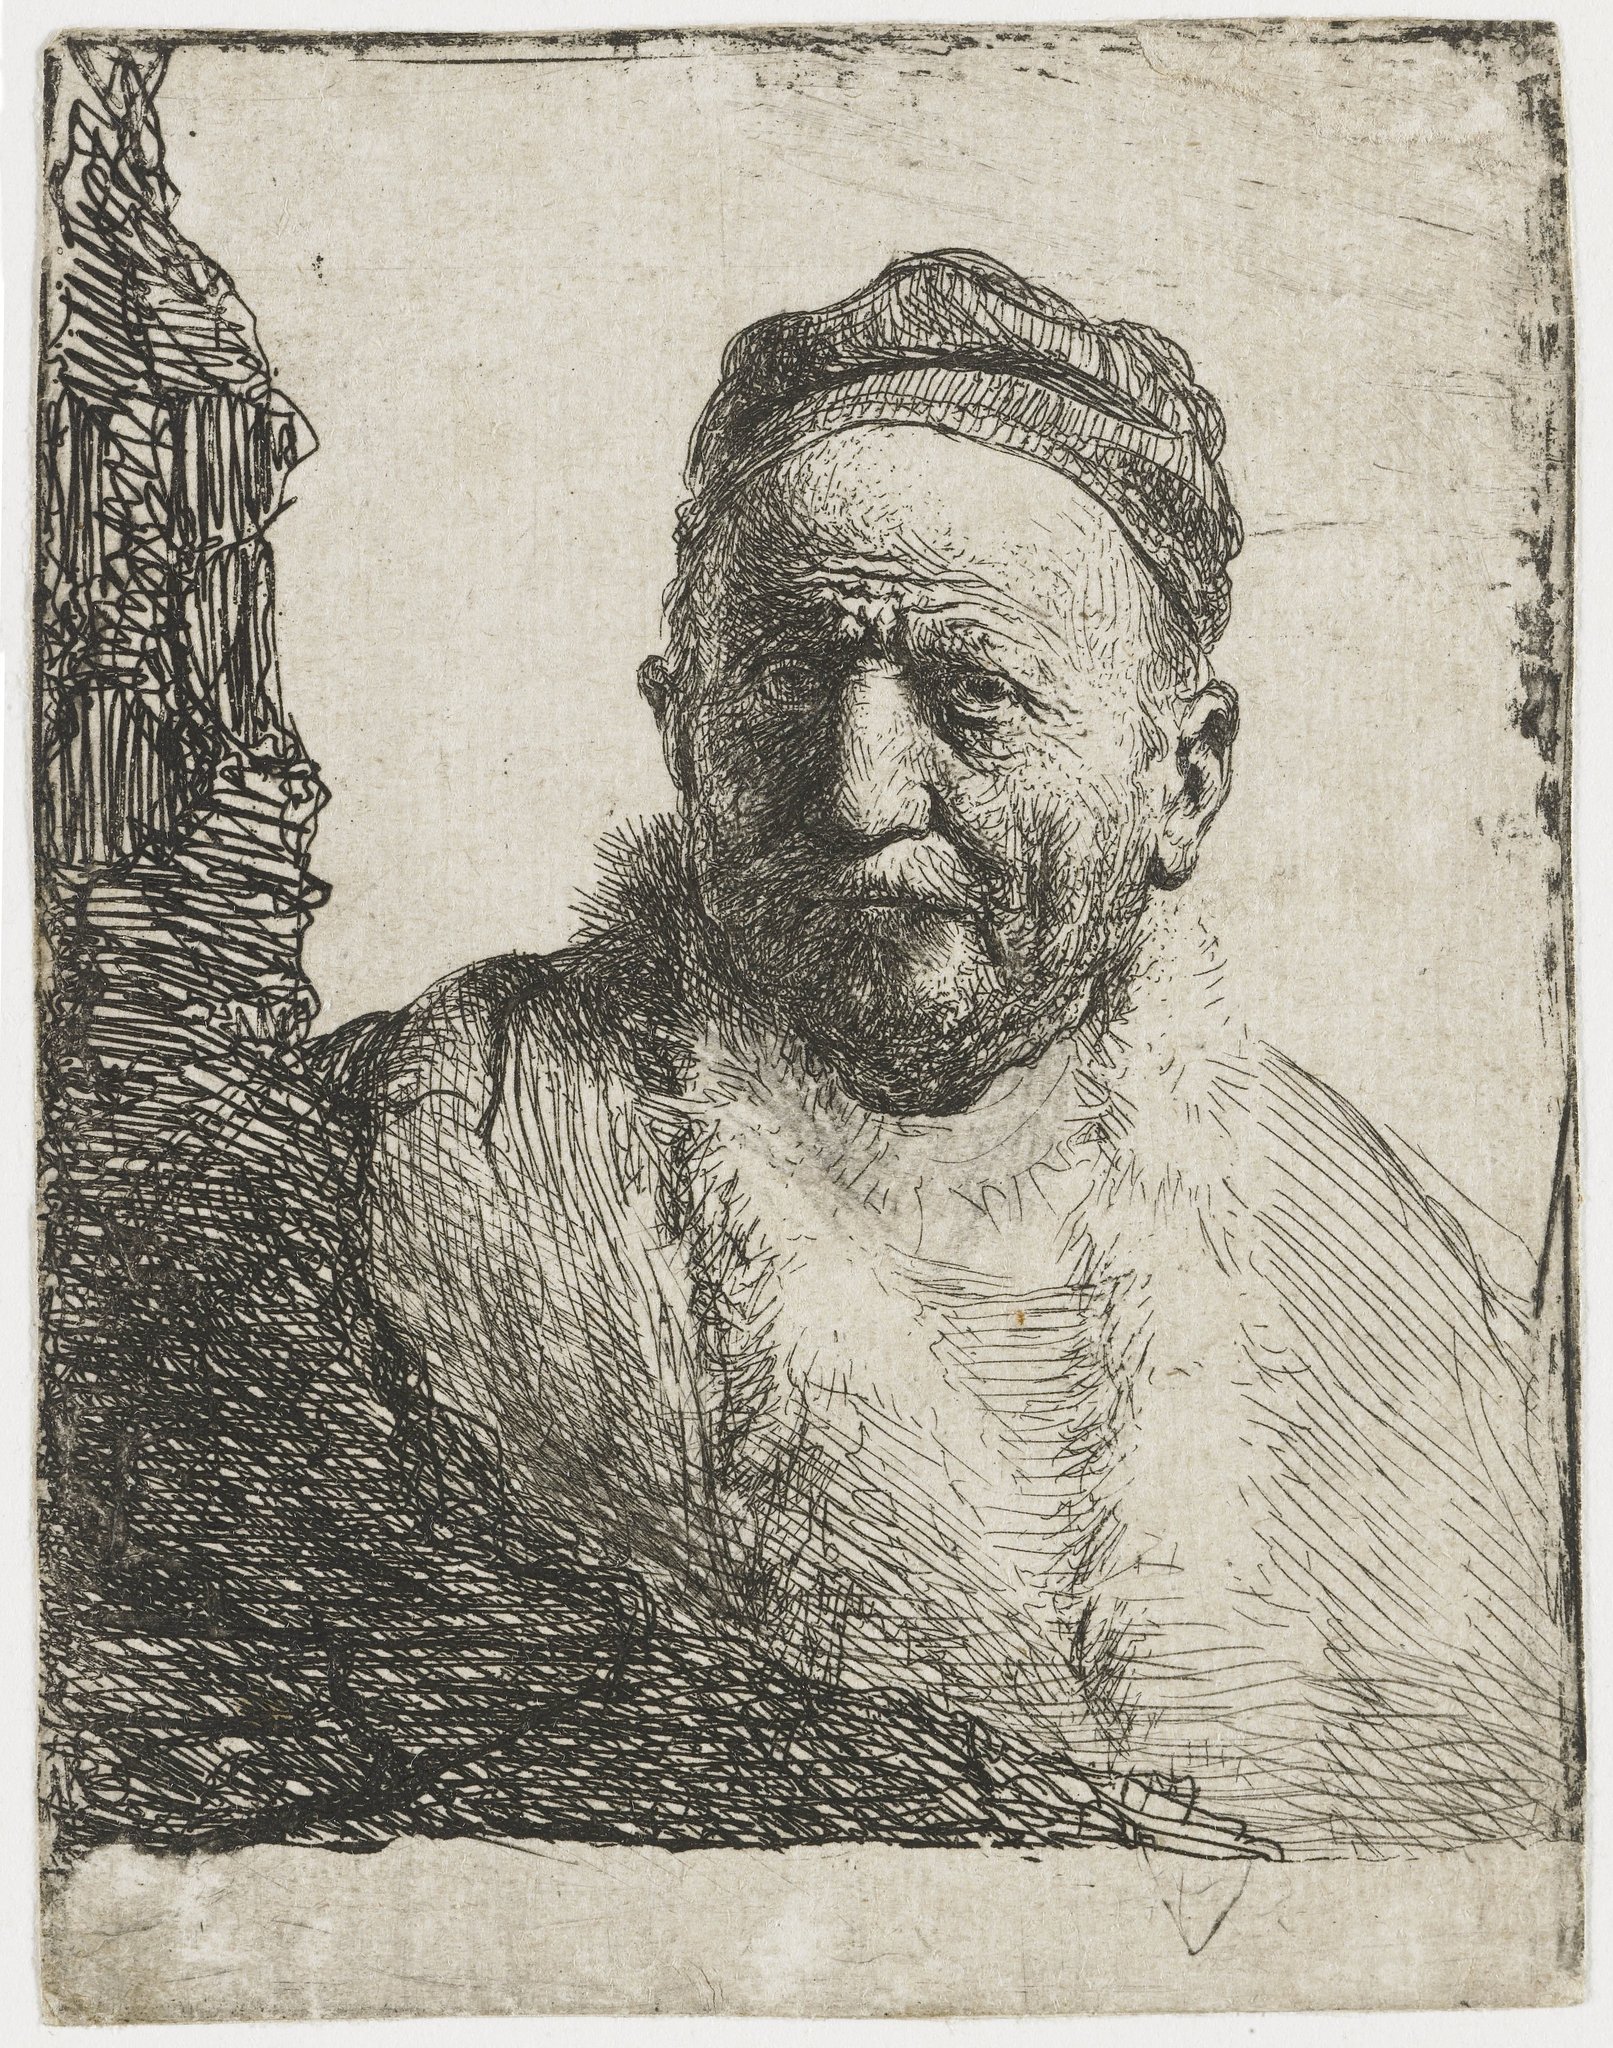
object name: print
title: Man in a Close Cap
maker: rembrandt van rijn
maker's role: draughtsman, painter, print maker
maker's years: 1606-1669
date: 1630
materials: chalk, paper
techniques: etching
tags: can hook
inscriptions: mark: Lugt 2165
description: The old man in these four little etchings has traditionally been identified as Rembrandt’s father, Harmen Gerritsz van Rijn. Whether this is actually the case remains uncertain, but it is striking that Rembrandt made them all in 1630, the year of his father’s death. He depicts the wrinkled skin so precisely that it is possible that he worked directly on the etching plate while his model sat to him.